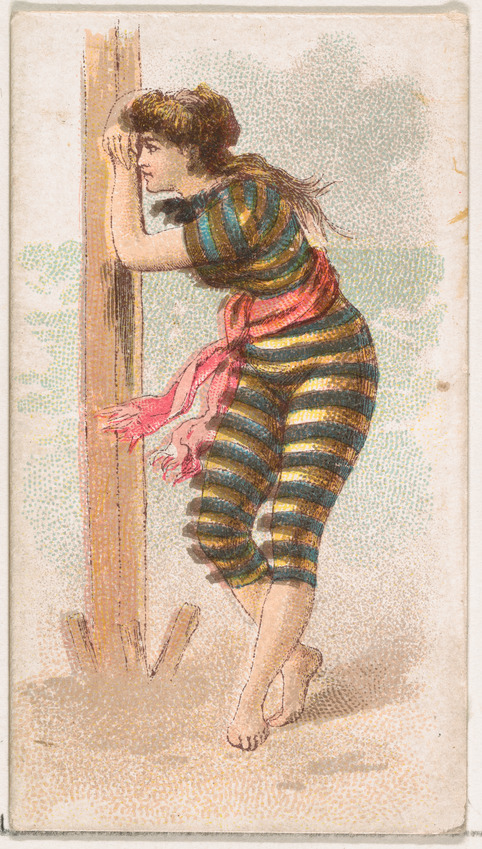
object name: print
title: Newport, from the Fancy Bathers series (N187) issued by Wm. S. Kimball & Co.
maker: william s. kimball & company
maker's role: publisher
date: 1889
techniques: color lithograph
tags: profiles,women